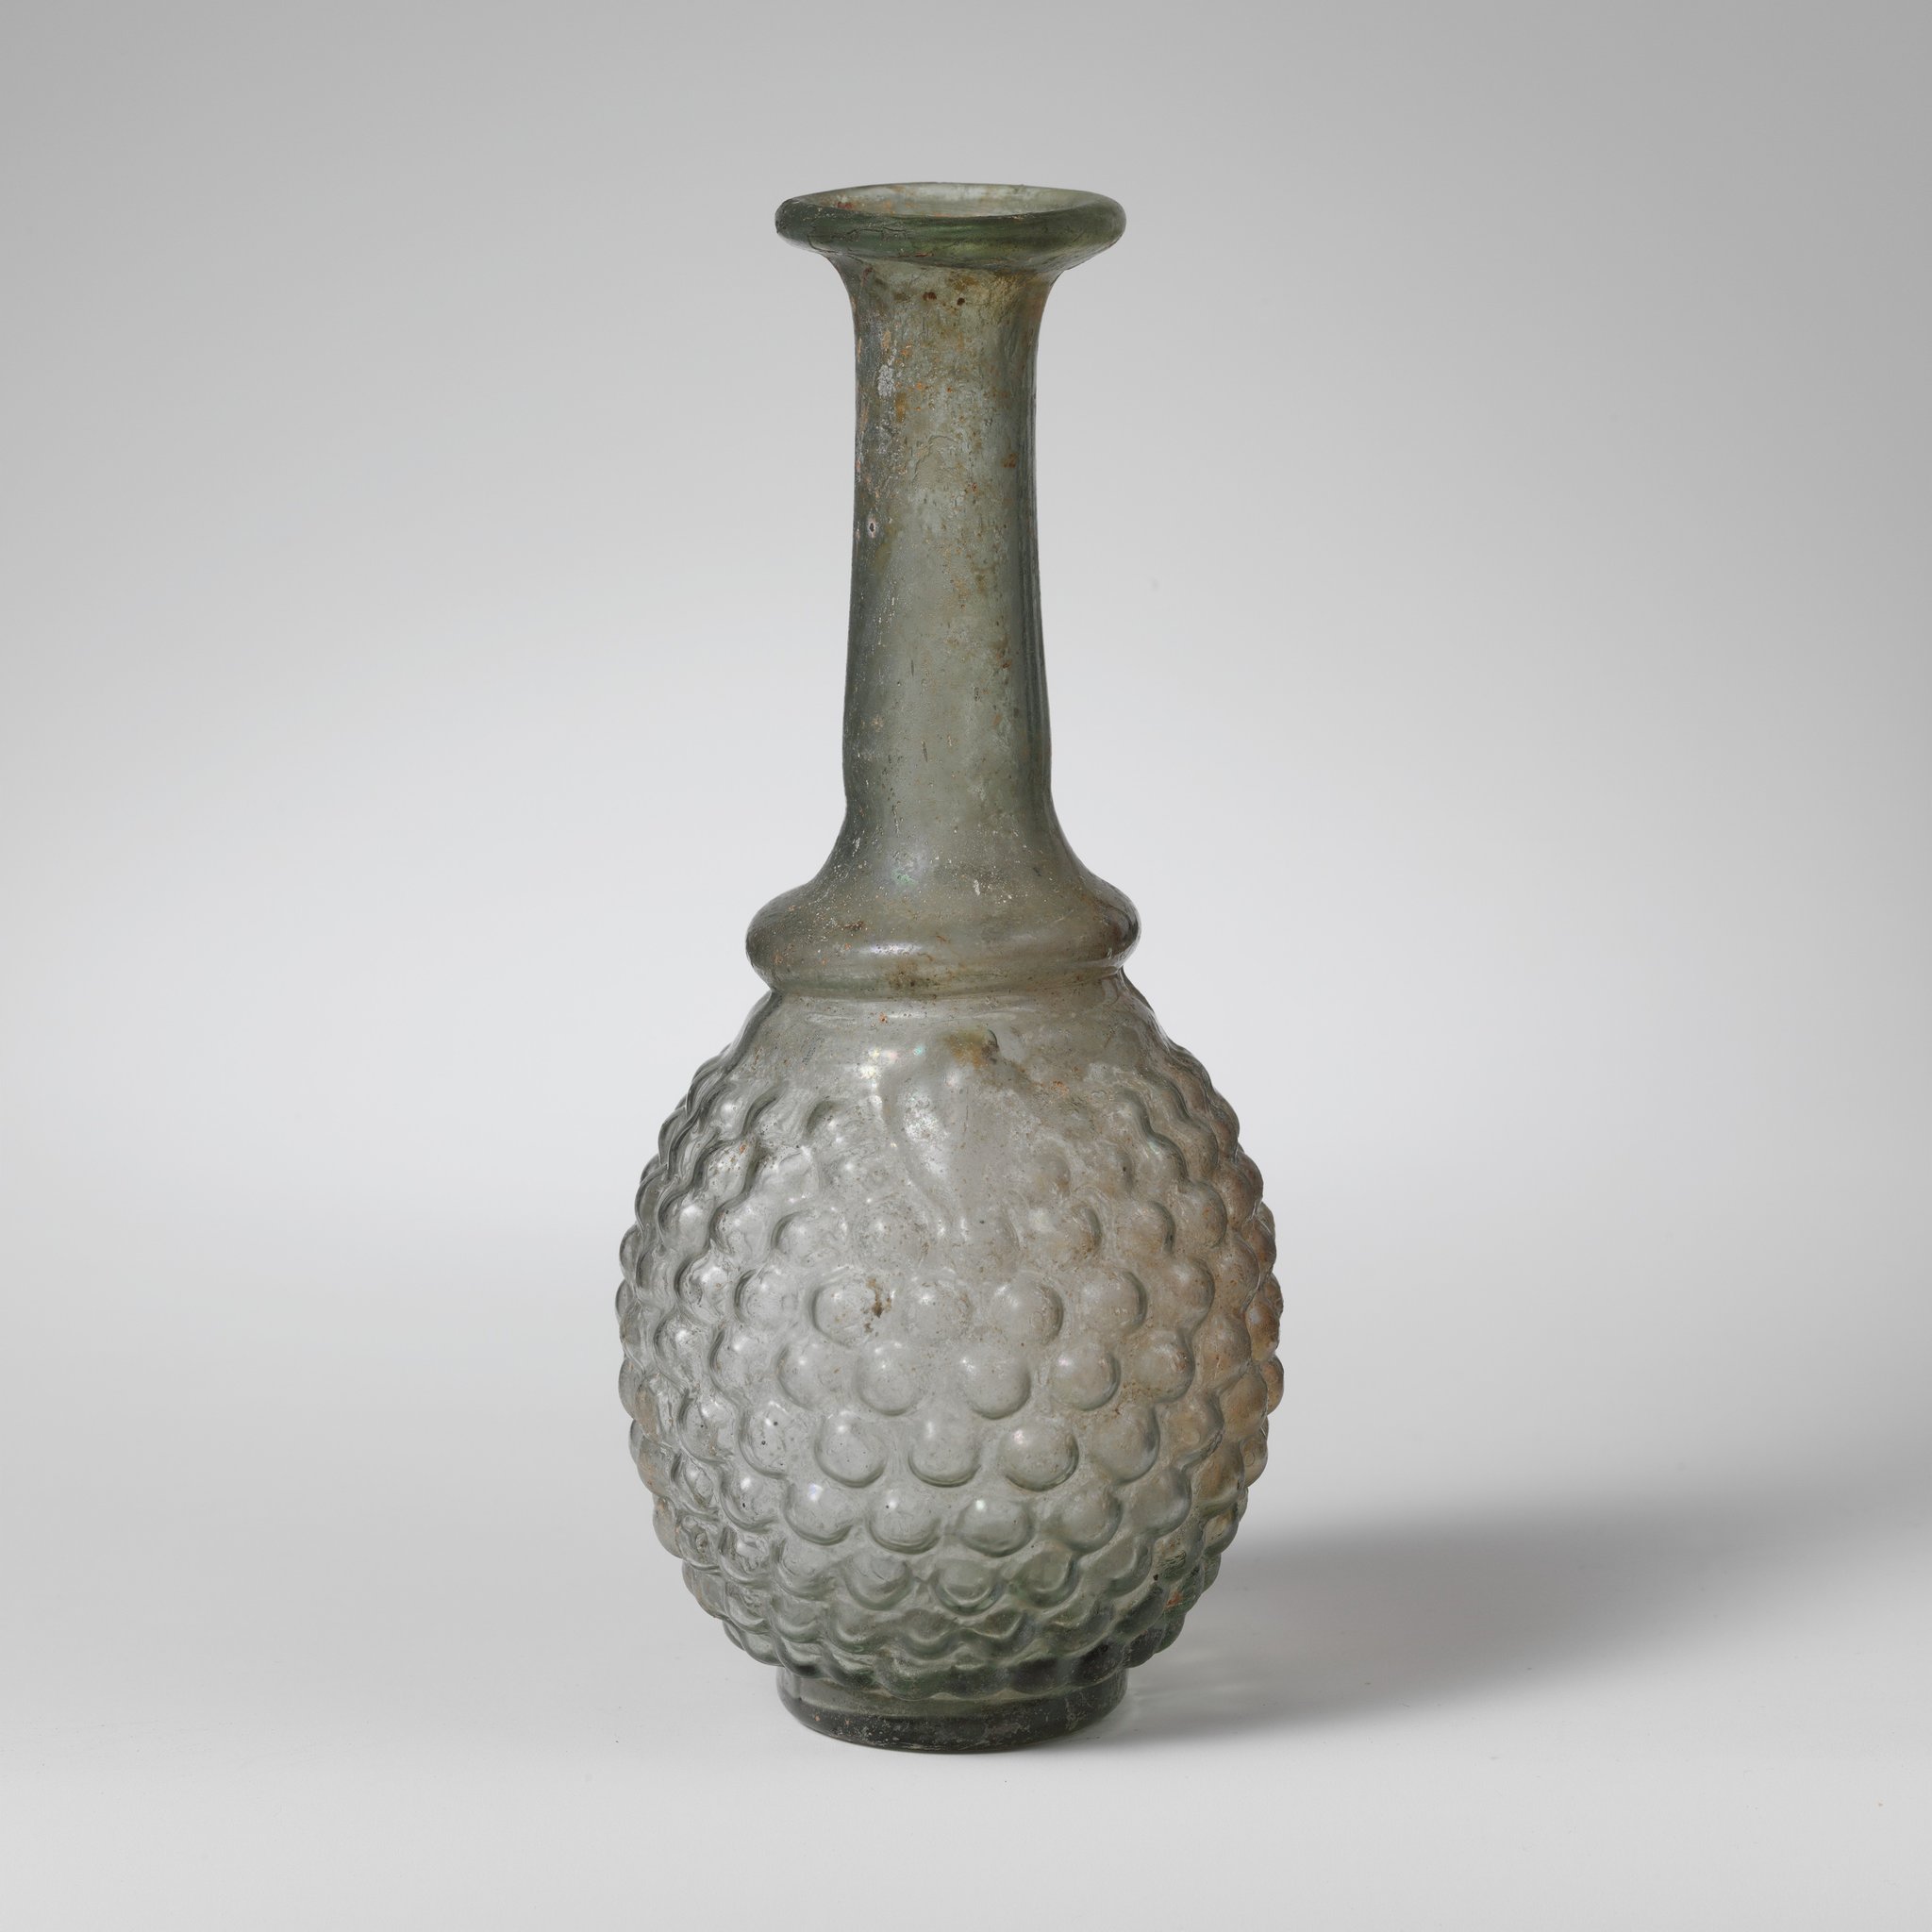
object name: bottle with stylized grape cluster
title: Glass bottle shaped like a bunch of grapes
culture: roman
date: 201-300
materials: glass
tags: grapes